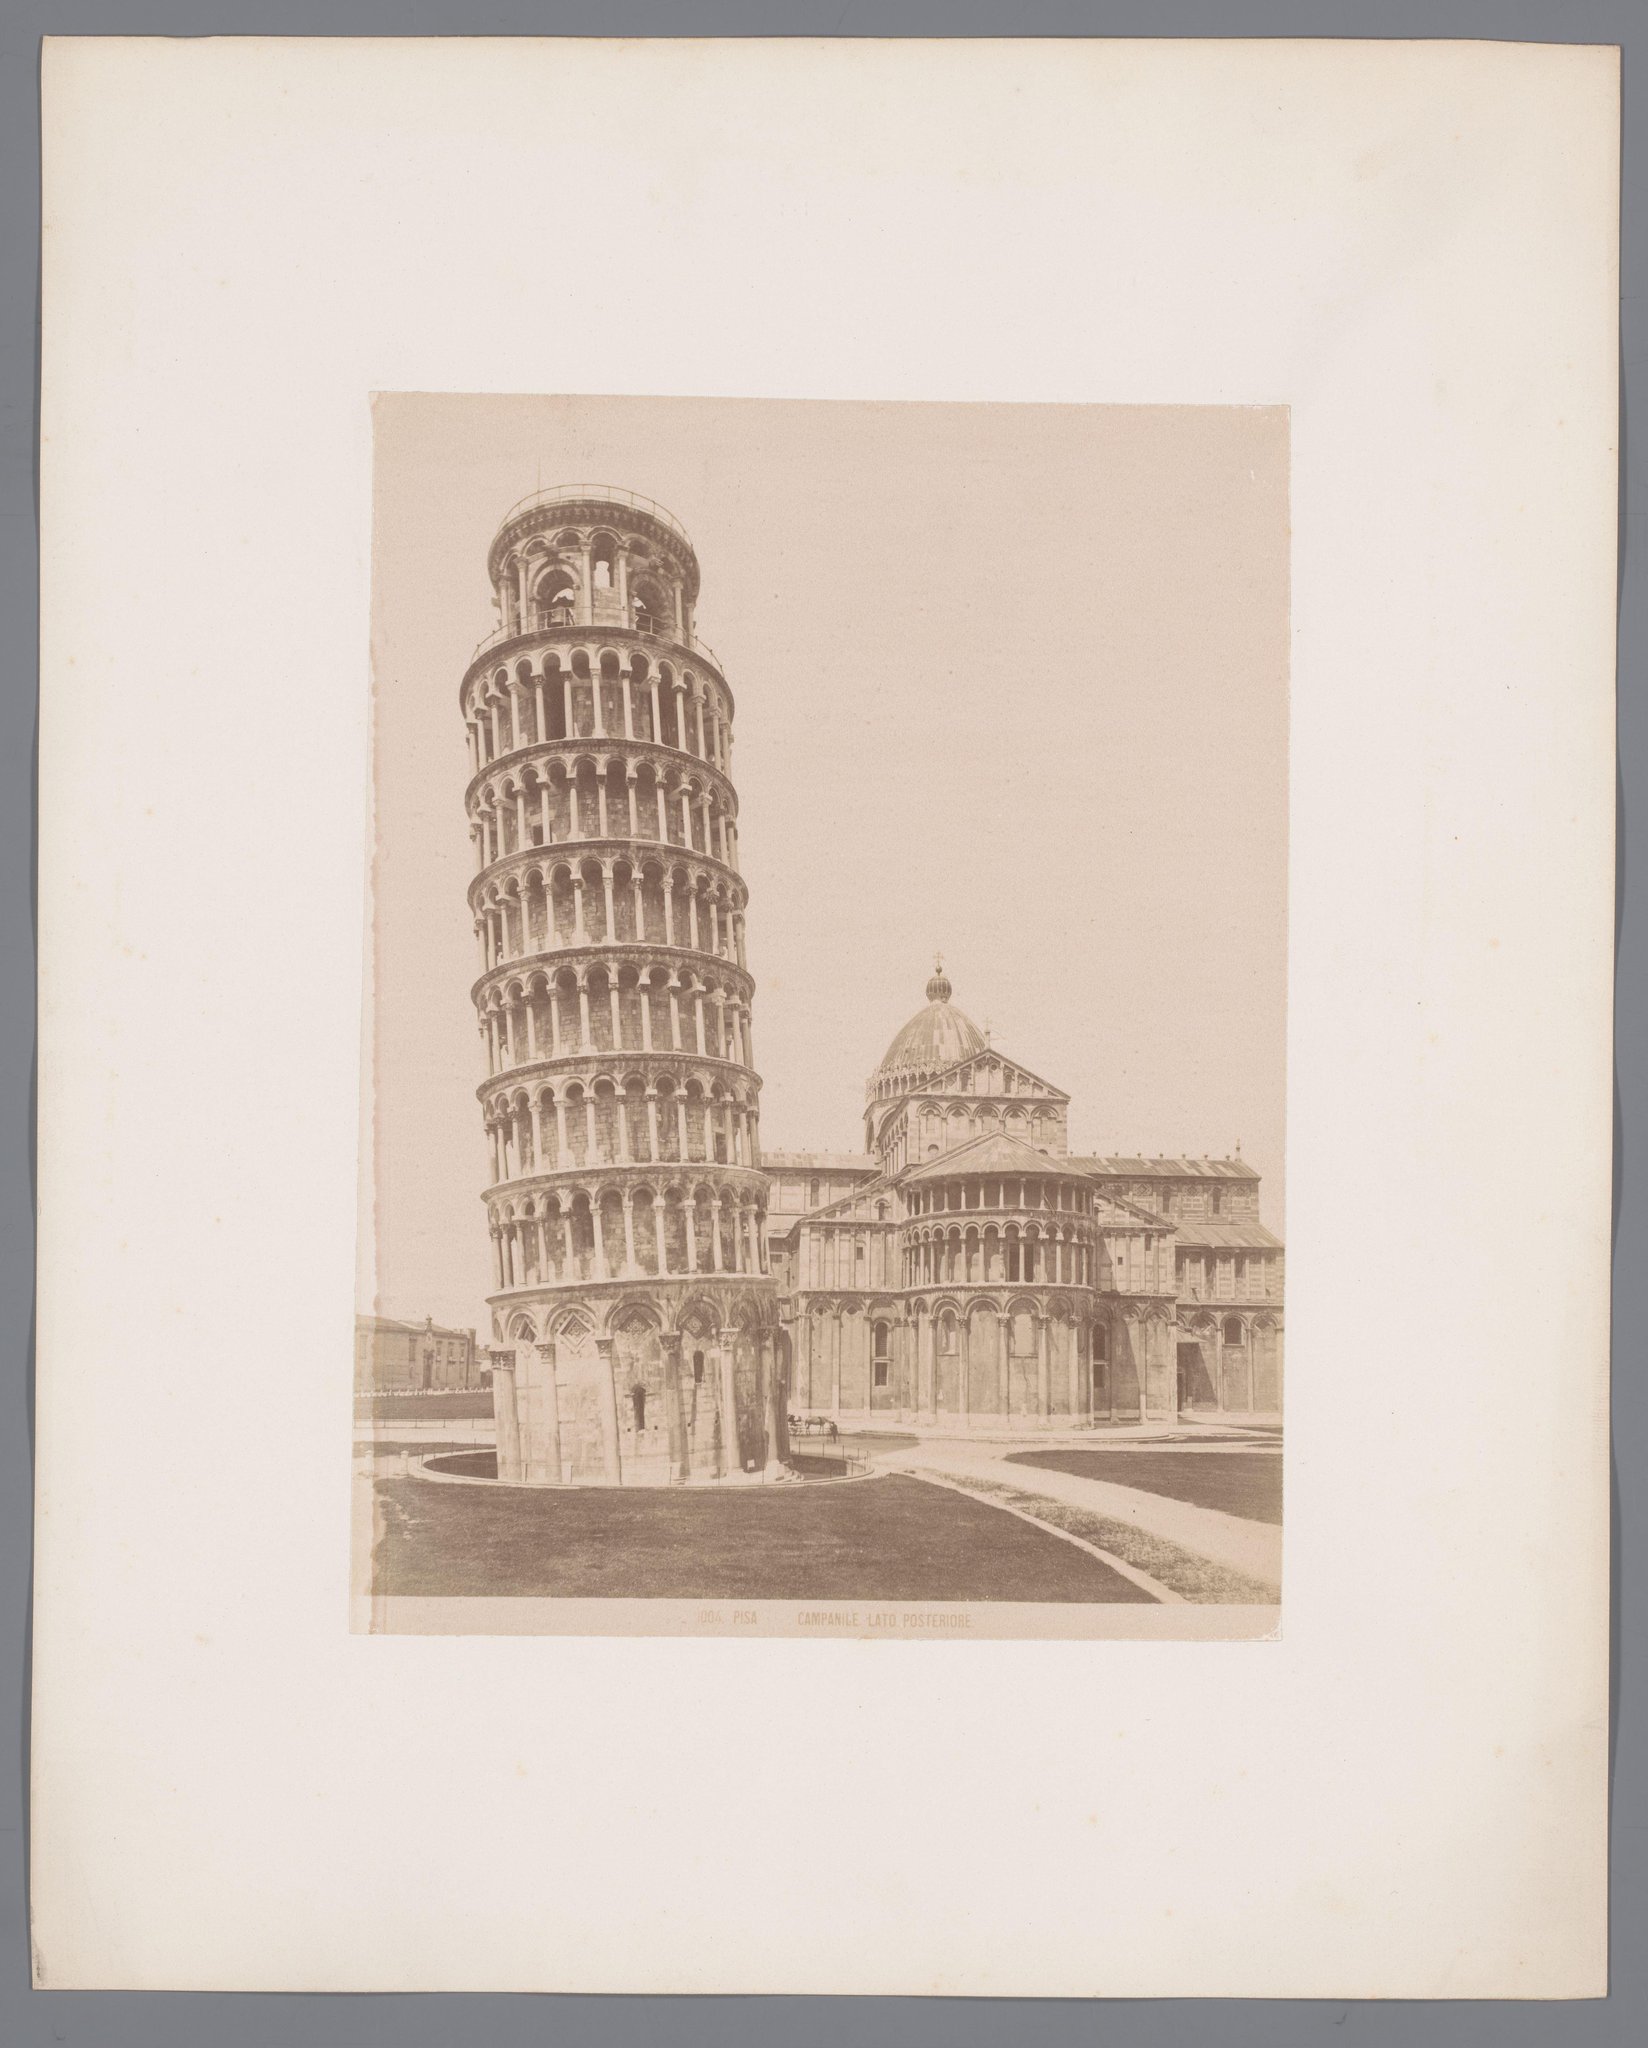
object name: photograph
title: Pisa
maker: Anonymous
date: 1851-1900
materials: cardboard, paper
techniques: albumen print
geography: pisa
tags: parts of church exterior and annexes: campanile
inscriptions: number: ‘1004.’